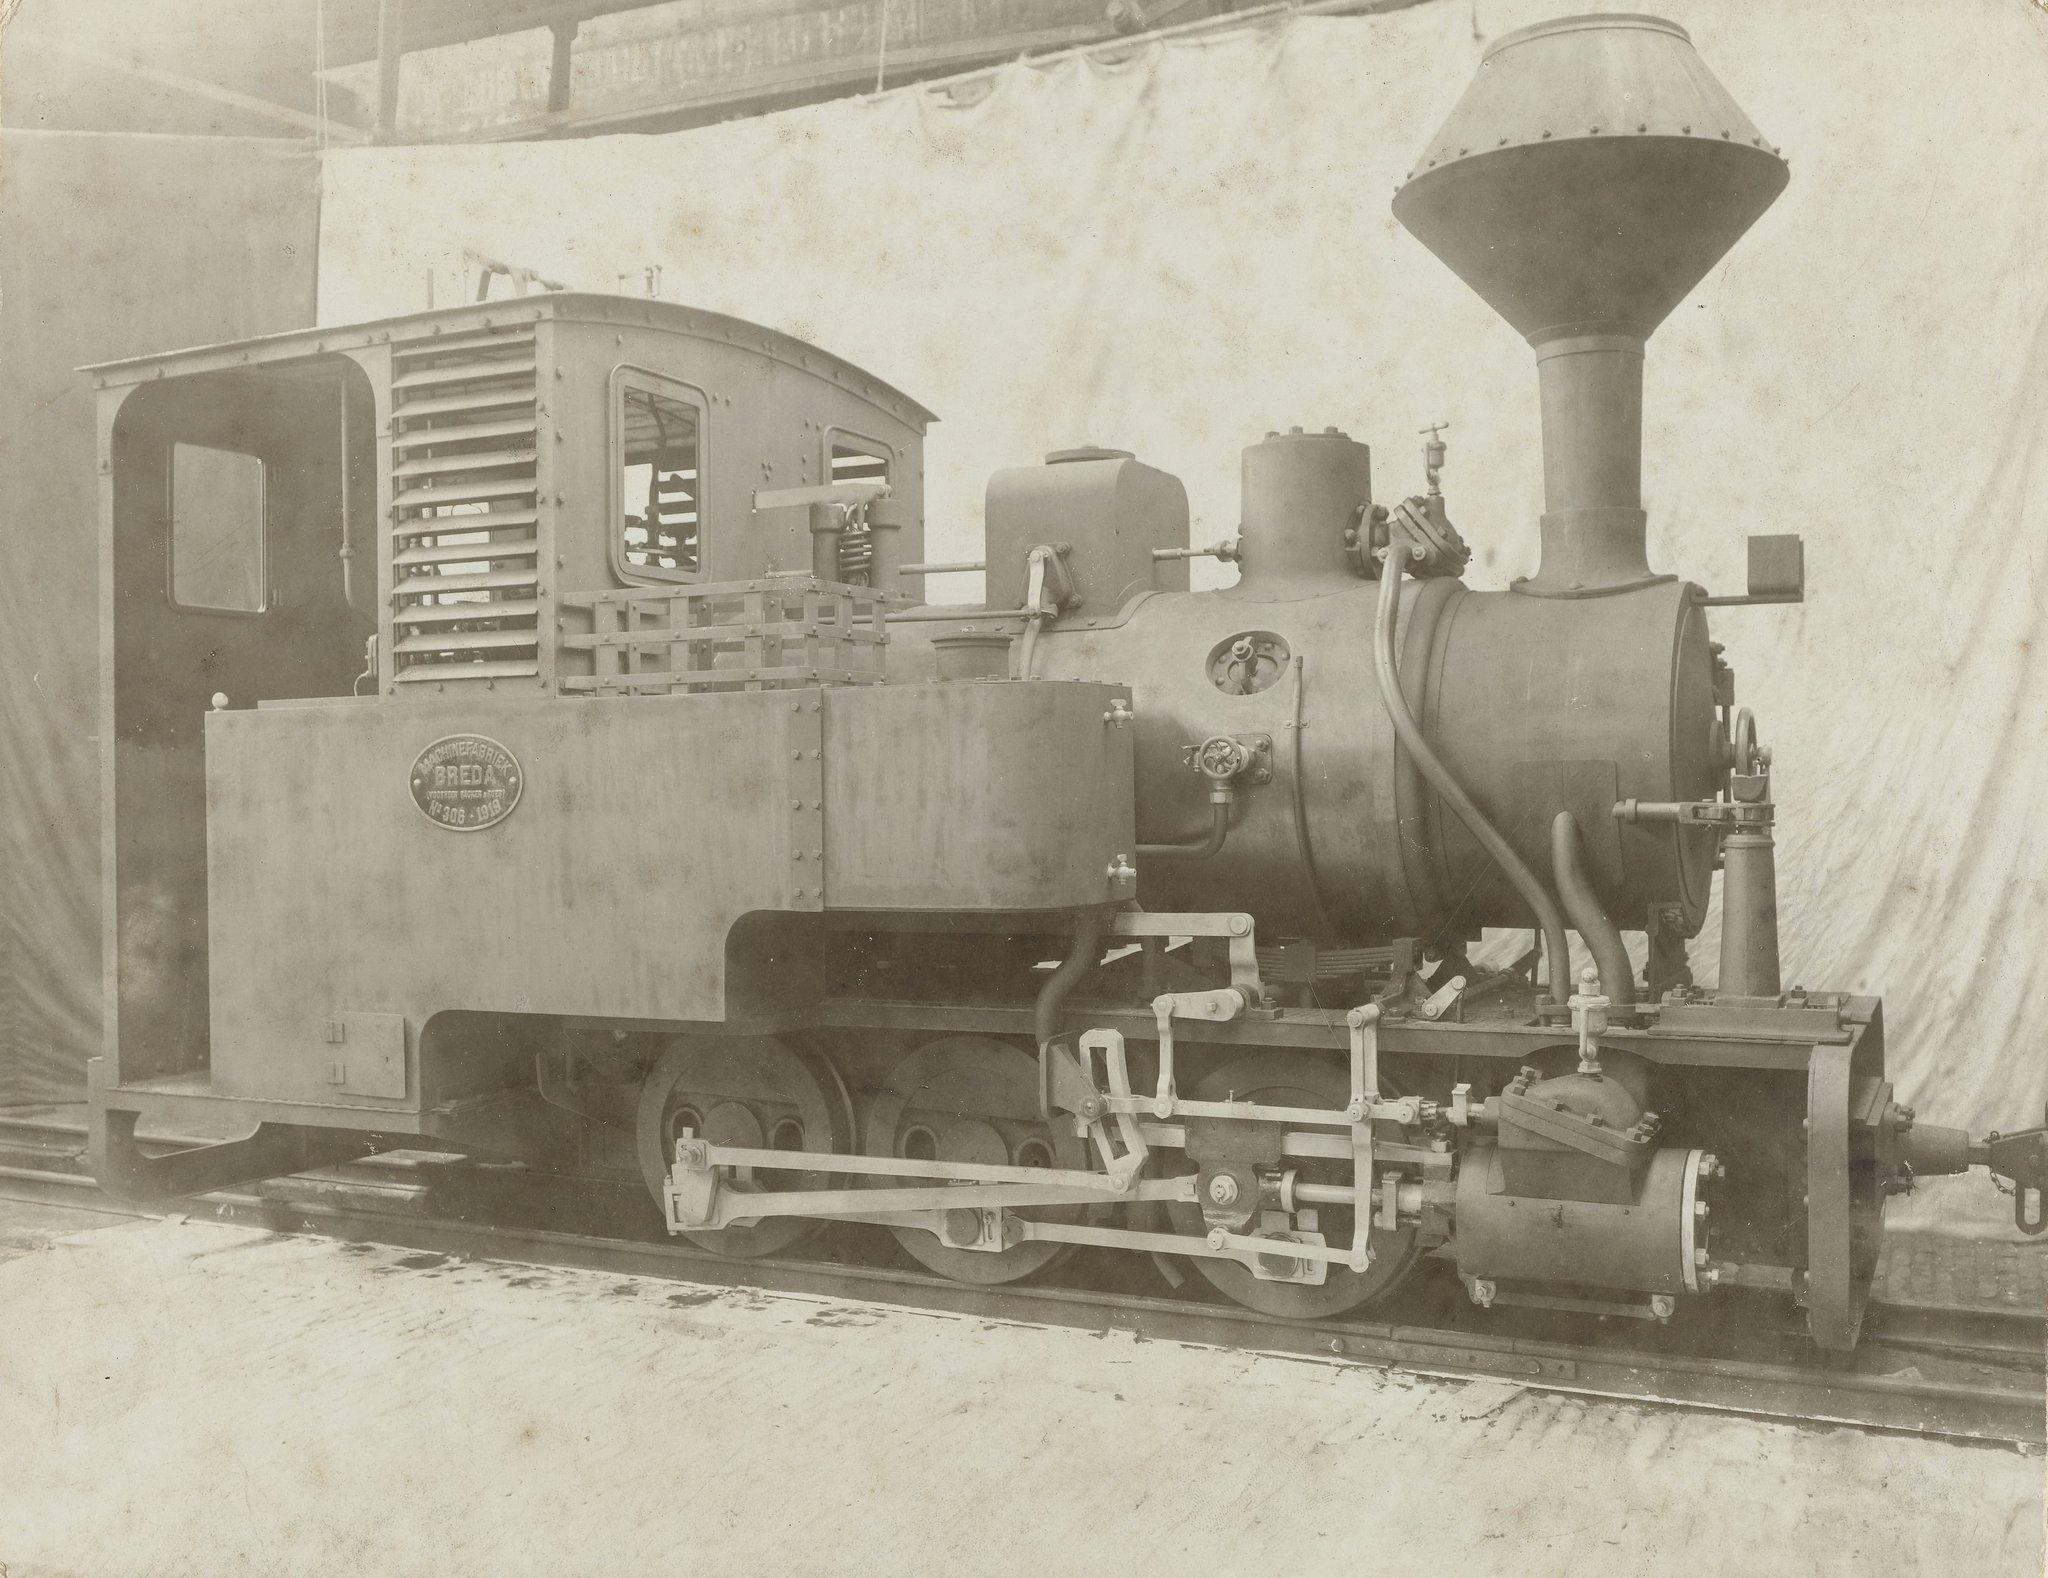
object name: photograph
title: Een suikerlocomotief van de Nederlandsch-Indische Spoorwegen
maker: Anonymous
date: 1900-1919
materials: paper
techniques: photography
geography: breda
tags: dutch east indies, the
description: Een stoomlocomotief in de fabriek. De laatste stoomlocomotief die door machinefabriek Breda is gebouwd, in 1916 verscheept naar de voormalige kolonie Nederlands-Indië. Gebruikt door de Banka en Biliton Mij. Gemaakt door de Machinefabriek Breda, nr. 306 - 1919.